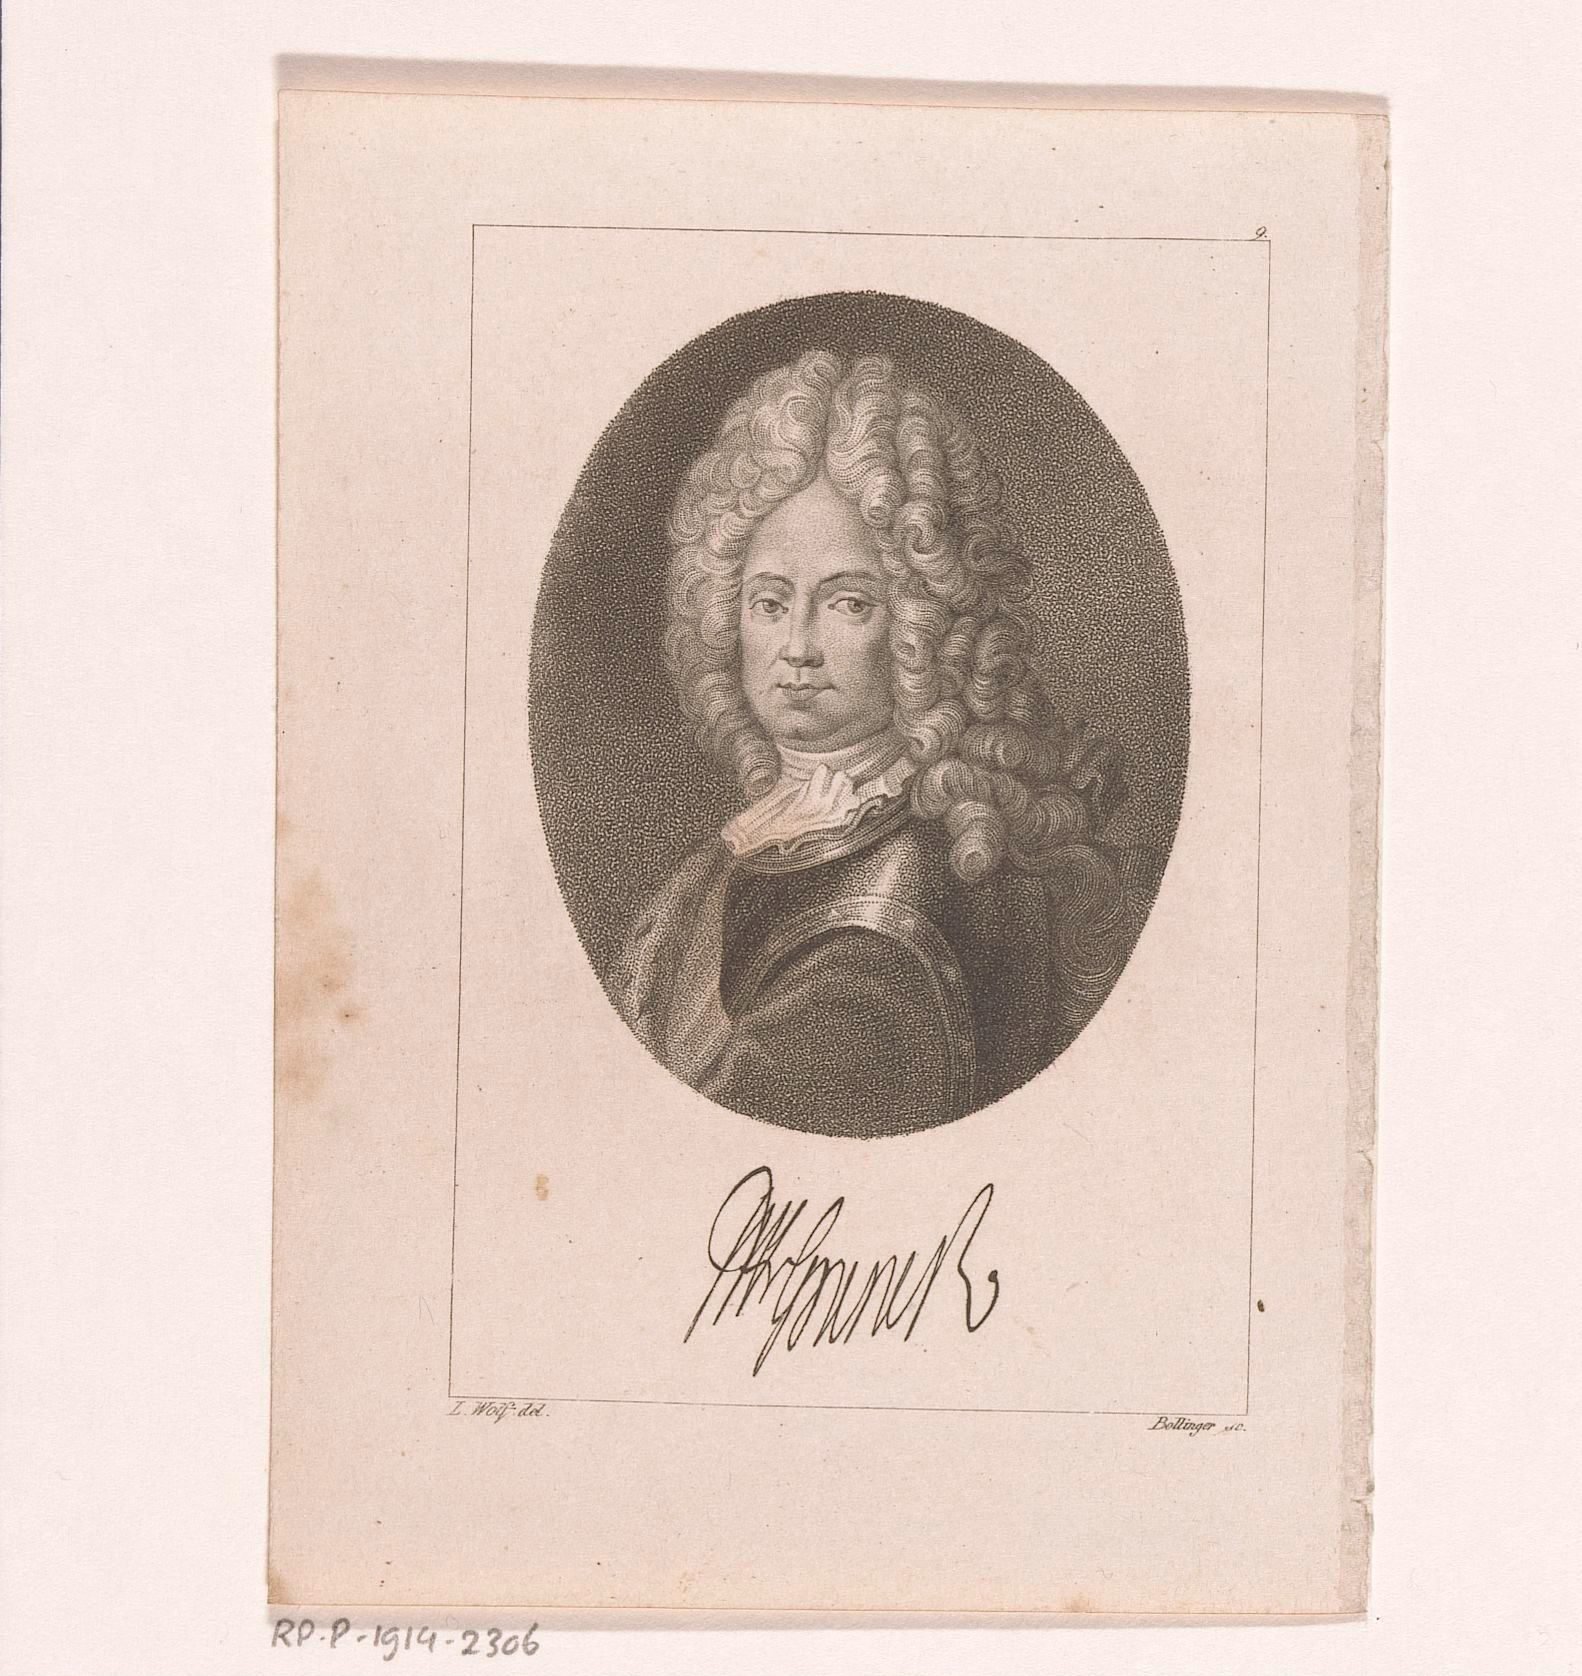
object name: print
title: Portret van Gottfried Christoph Beireis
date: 1818-1832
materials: paper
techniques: stippling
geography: zwickau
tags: mühlhausen, historical persons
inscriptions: collector's mark: Lugt 2228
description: Prent gebruikt door de serie 'Bildnisse der berühmtesten Menschen aller Völker und Zeiten' van de gebroeders Schumann, uitgegeven in 1818-1832 te Zwickau.